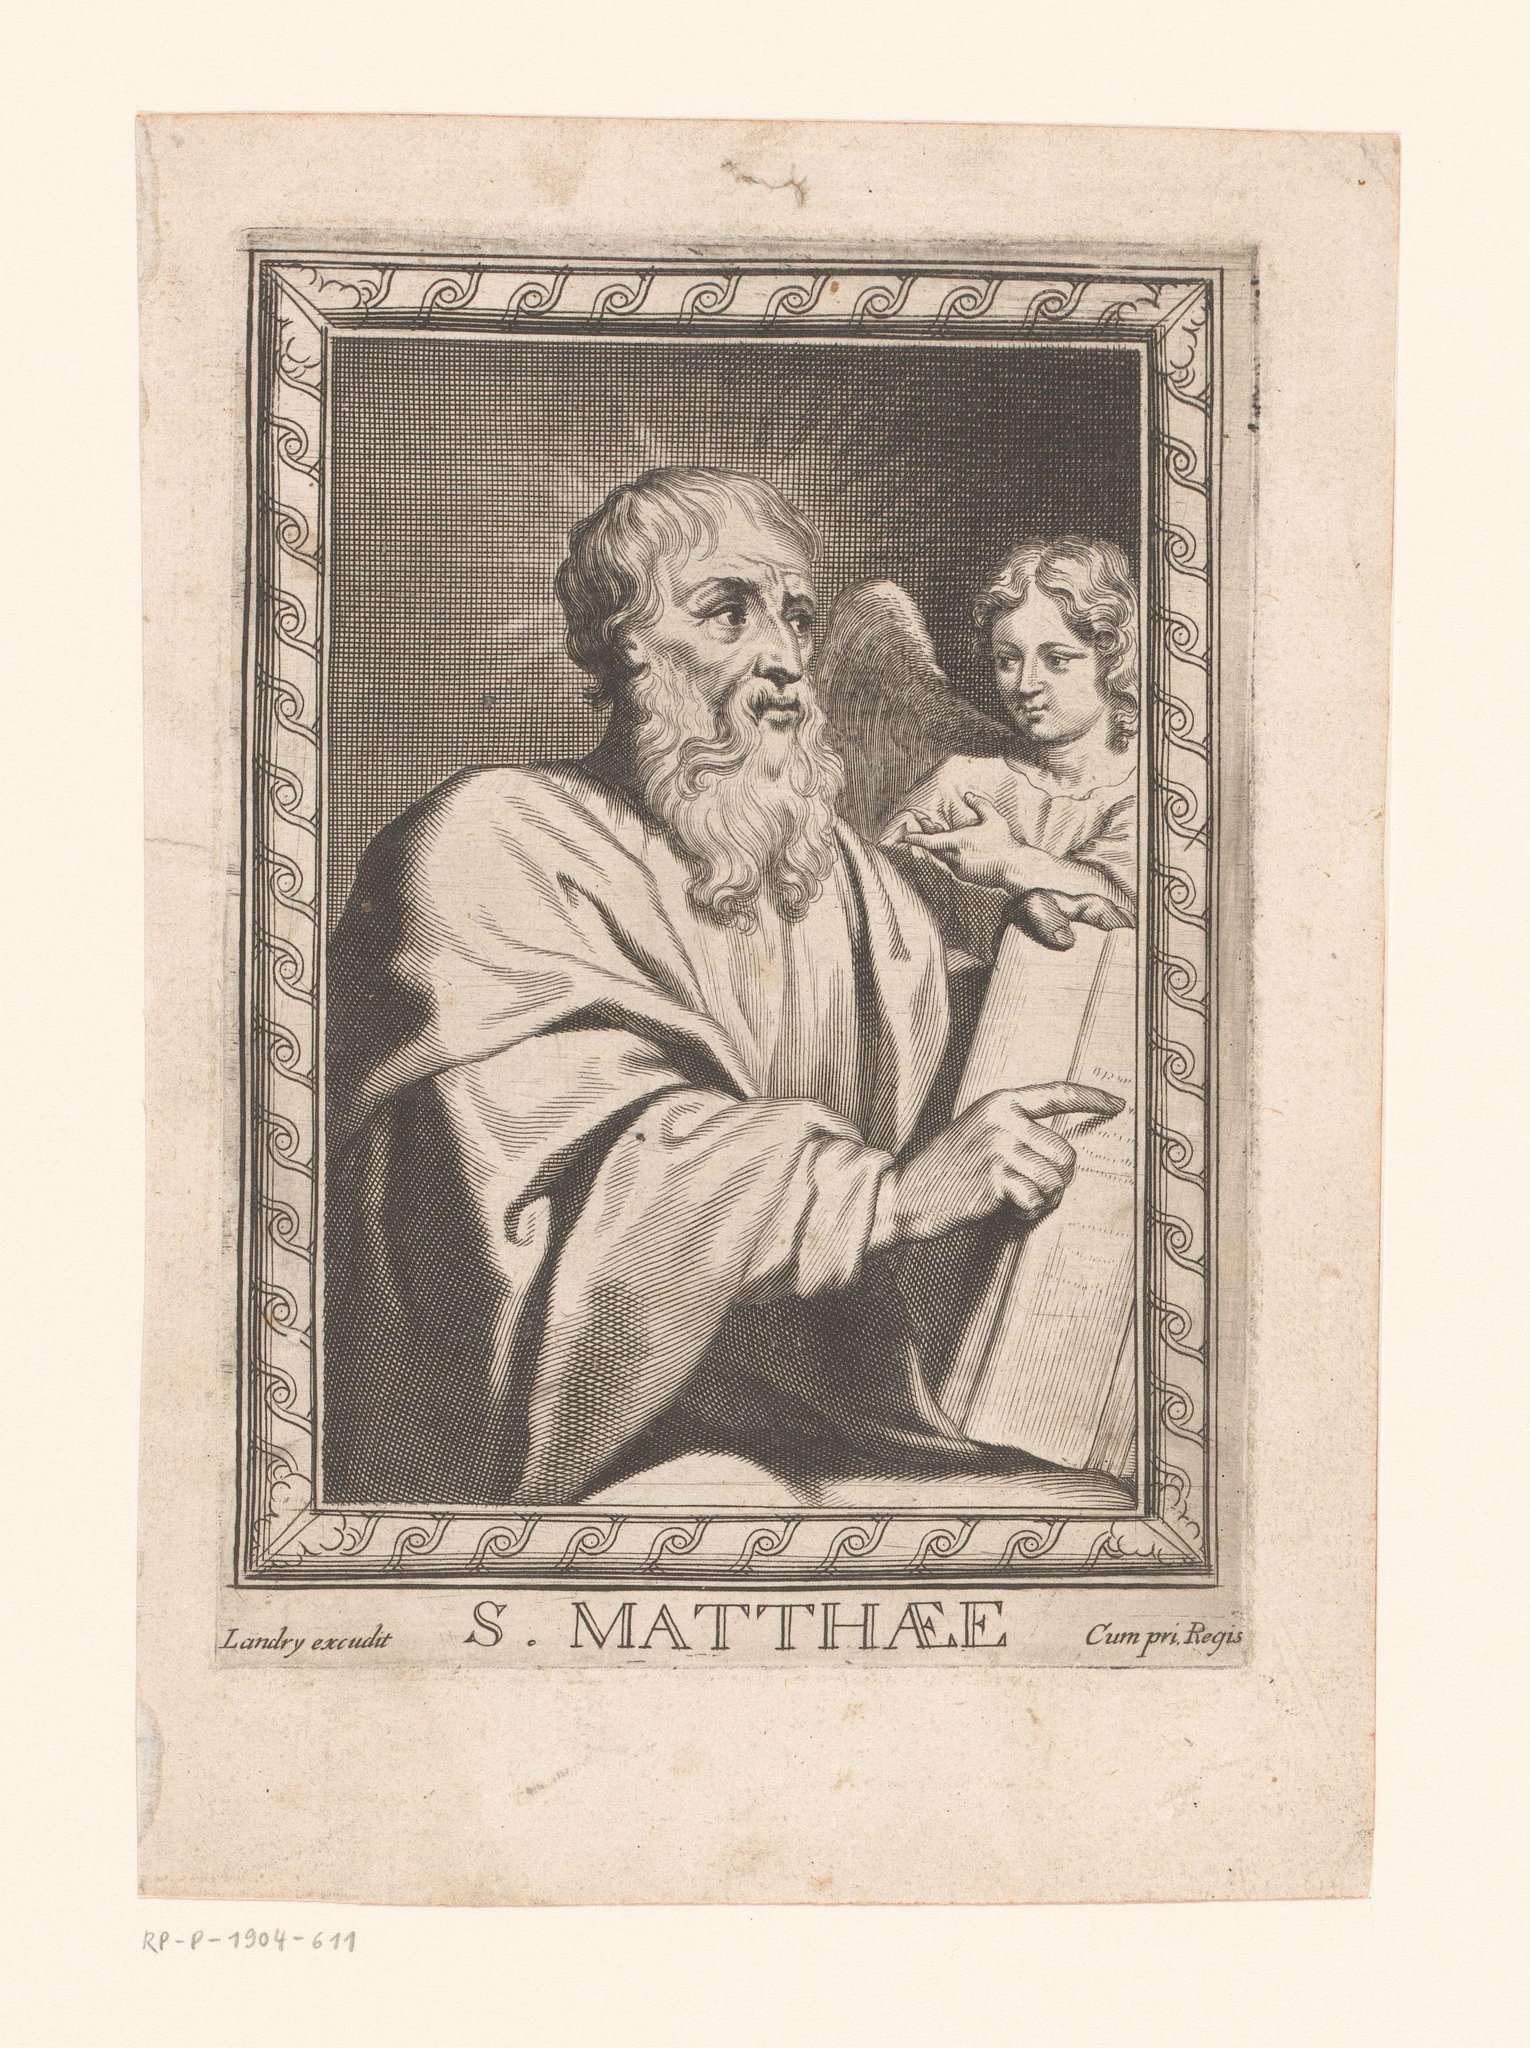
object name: print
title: S. Matthaee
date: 1640-1701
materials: paper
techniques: engraving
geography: france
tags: the apostle and evangelist matthew (mattheus); possible attributes: angel, axe, book, halberd, pen and inkhorn, purse, scroll, square, sword, angel (possibly with book) ~ symbol of st. matthew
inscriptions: collector's mark: Lugt 2228